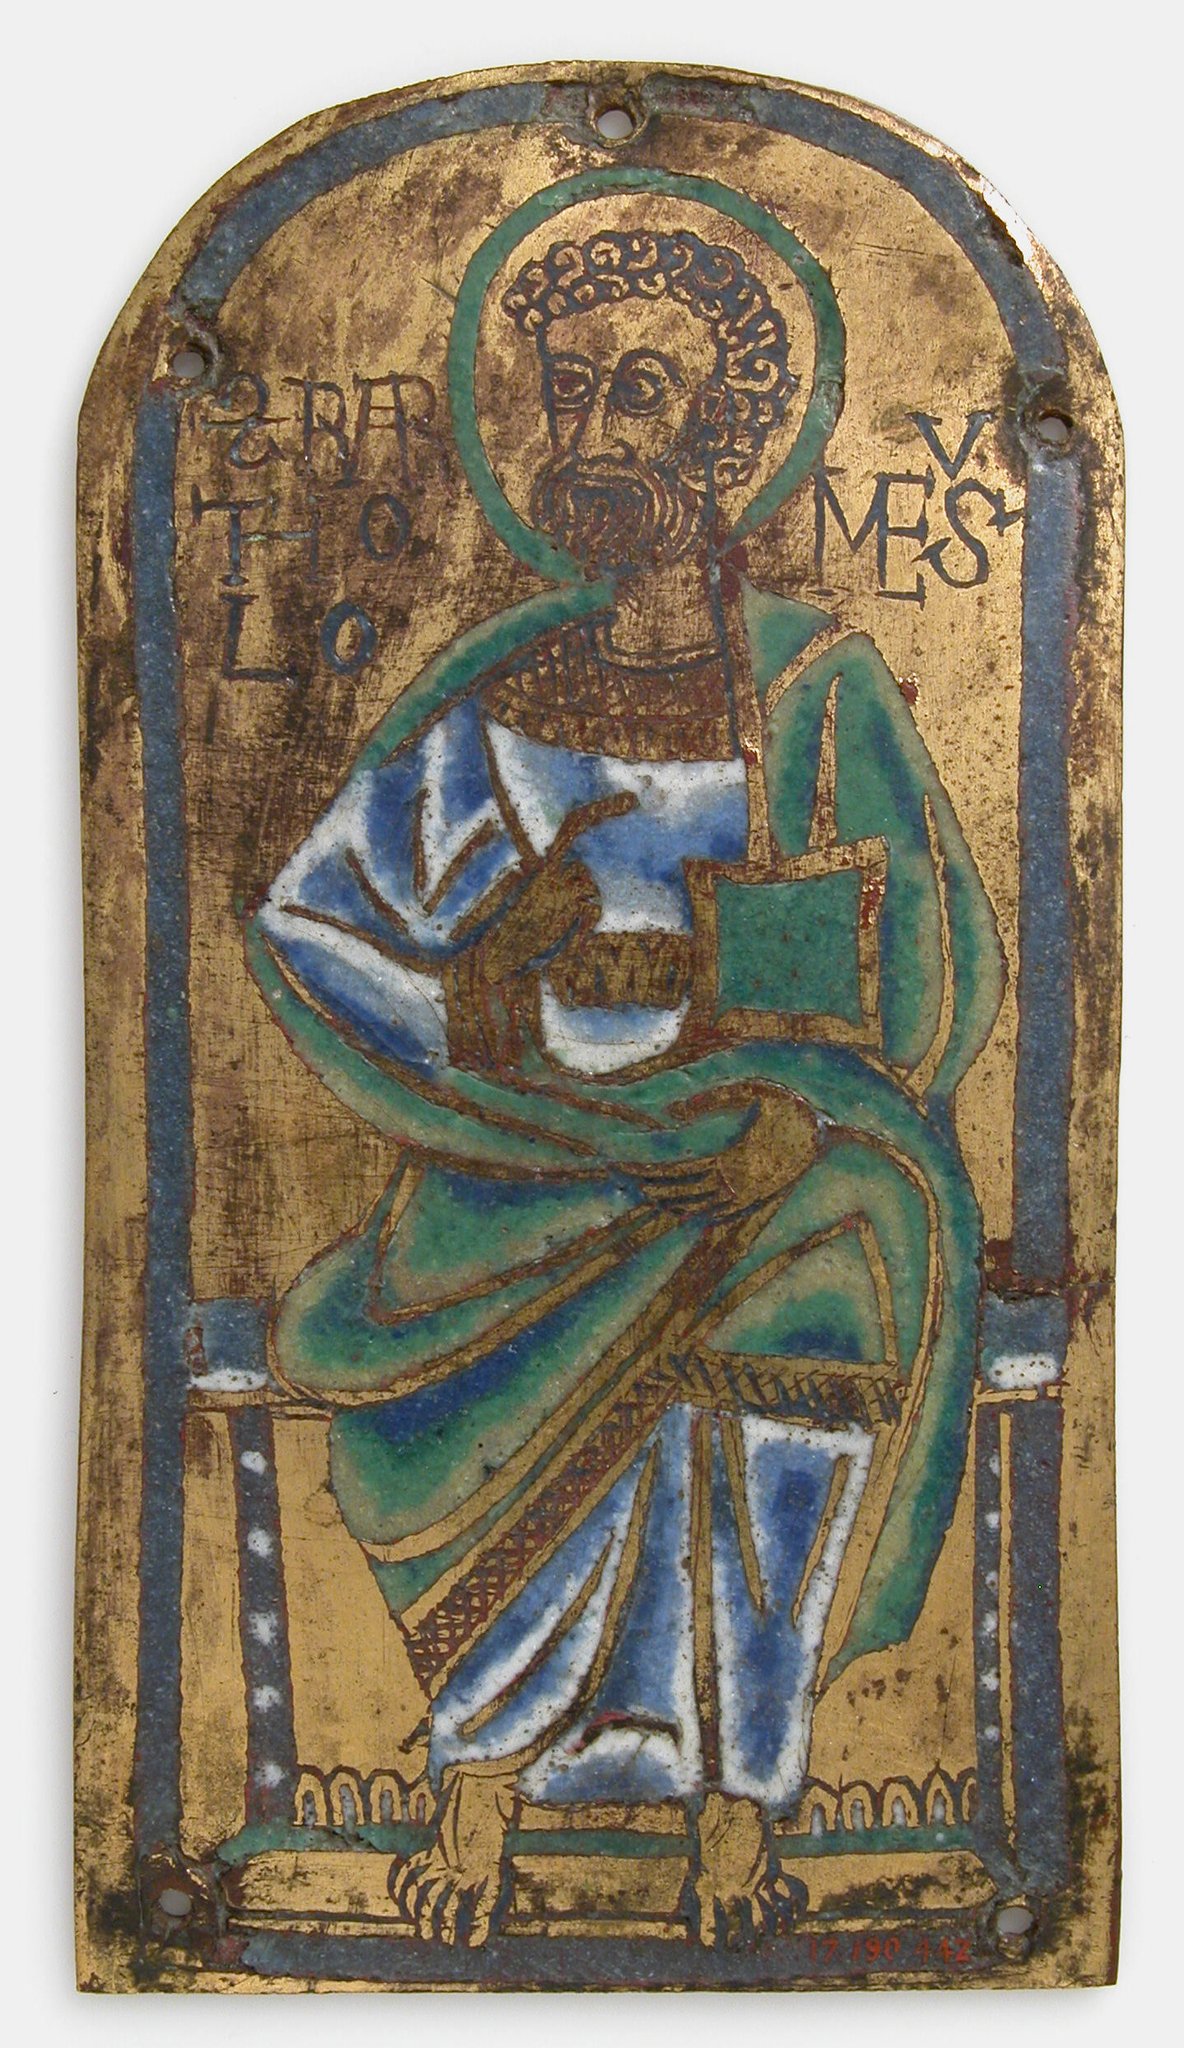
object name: plaque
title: Plaque of St. Bartholomew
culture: rhenish or saxon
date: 1134-1166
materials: gilt copper, enamel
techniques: enamel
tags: saints